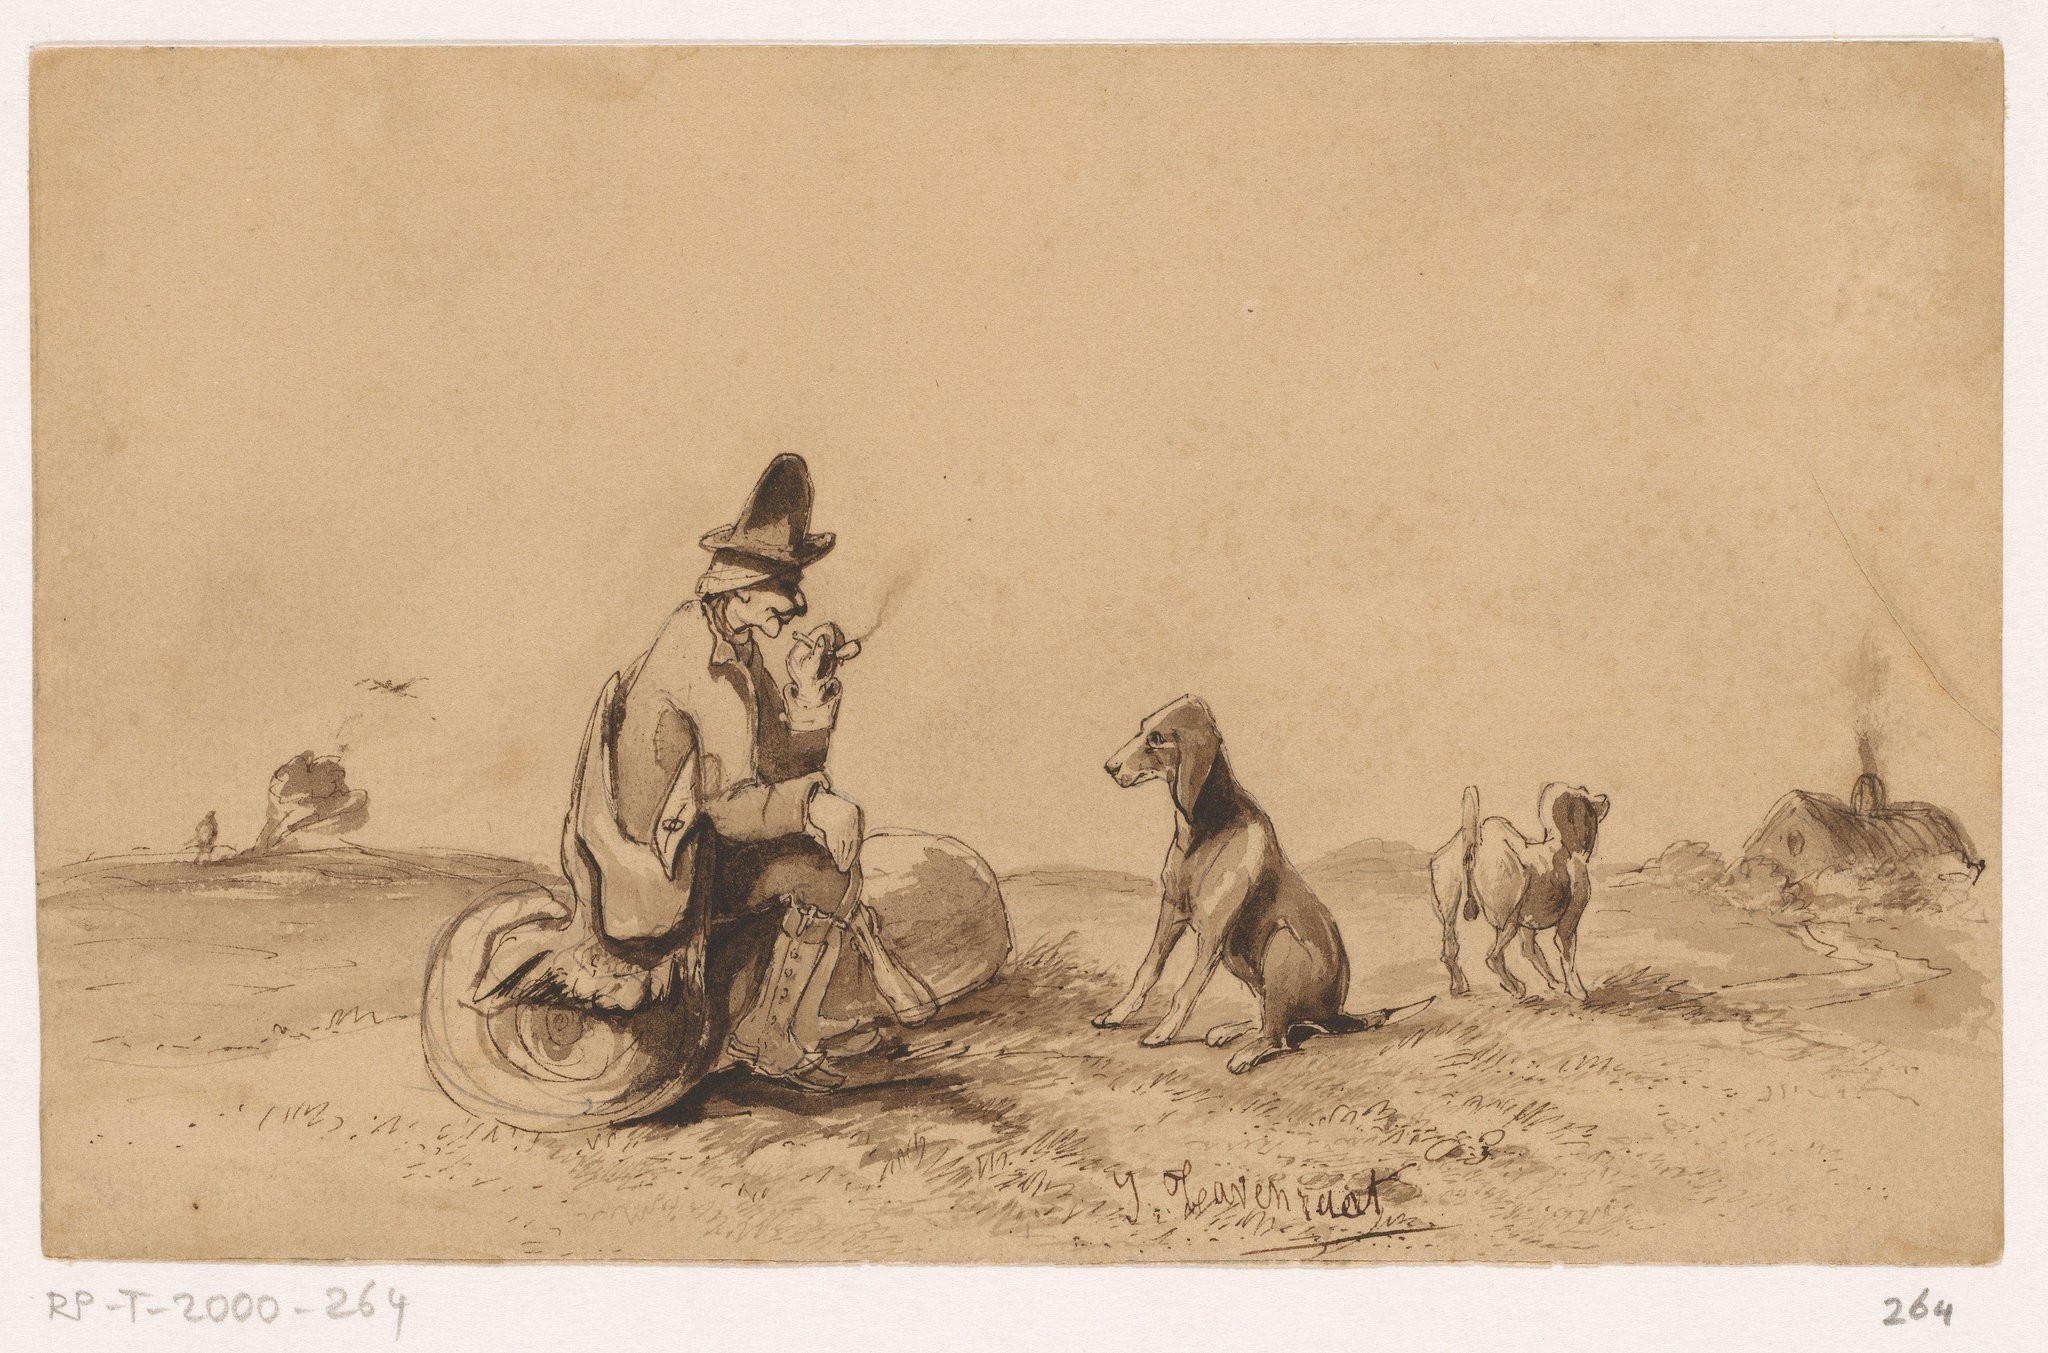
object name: drawing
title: Zittende man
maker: johannes tavenraat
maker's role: draughtsman, painter, print maker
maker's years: 1809-1881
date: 1840-1880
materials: ink, paper, pencil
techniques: brush, pen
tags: sitting figure, pipe ~ tobacco, dog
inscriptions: collector's mark: Lugt 2228, collector's mark: Lugt 3751, signature: ‘J. Tavenraat’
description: Man zittend op een boomstam, een pijp rokend. Met enkele honden.